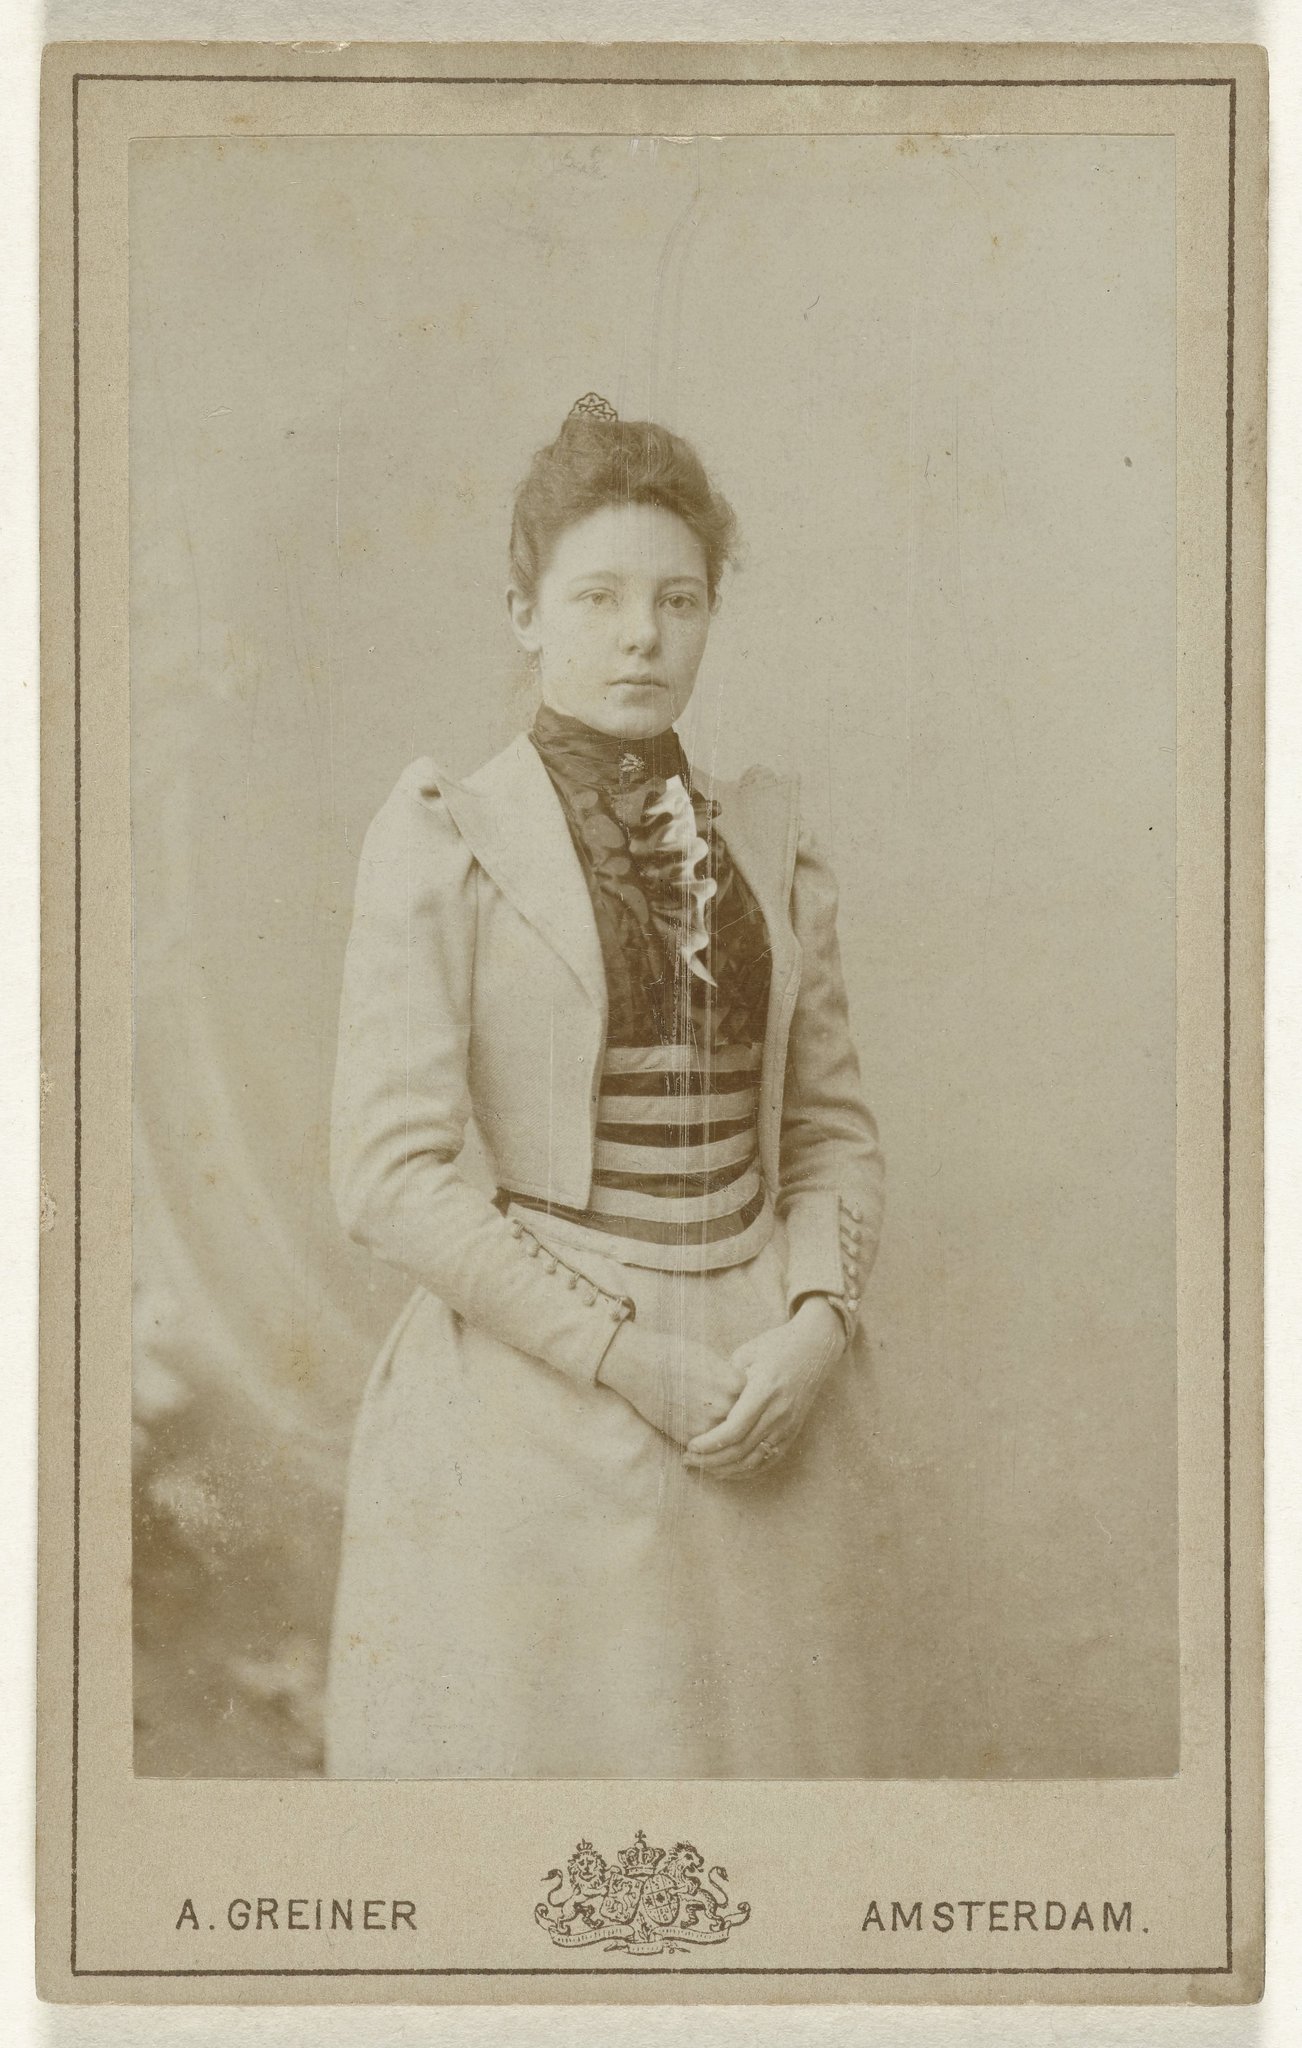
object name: carte de visite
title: Studioportret van een vrouw in een rok en een jasje met pofmouwen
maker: albert greiner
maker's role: fotograaf, fotostudio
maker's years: 1833-1890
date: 1890-1915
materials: paper, photographic support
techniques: photography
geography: amsterdam